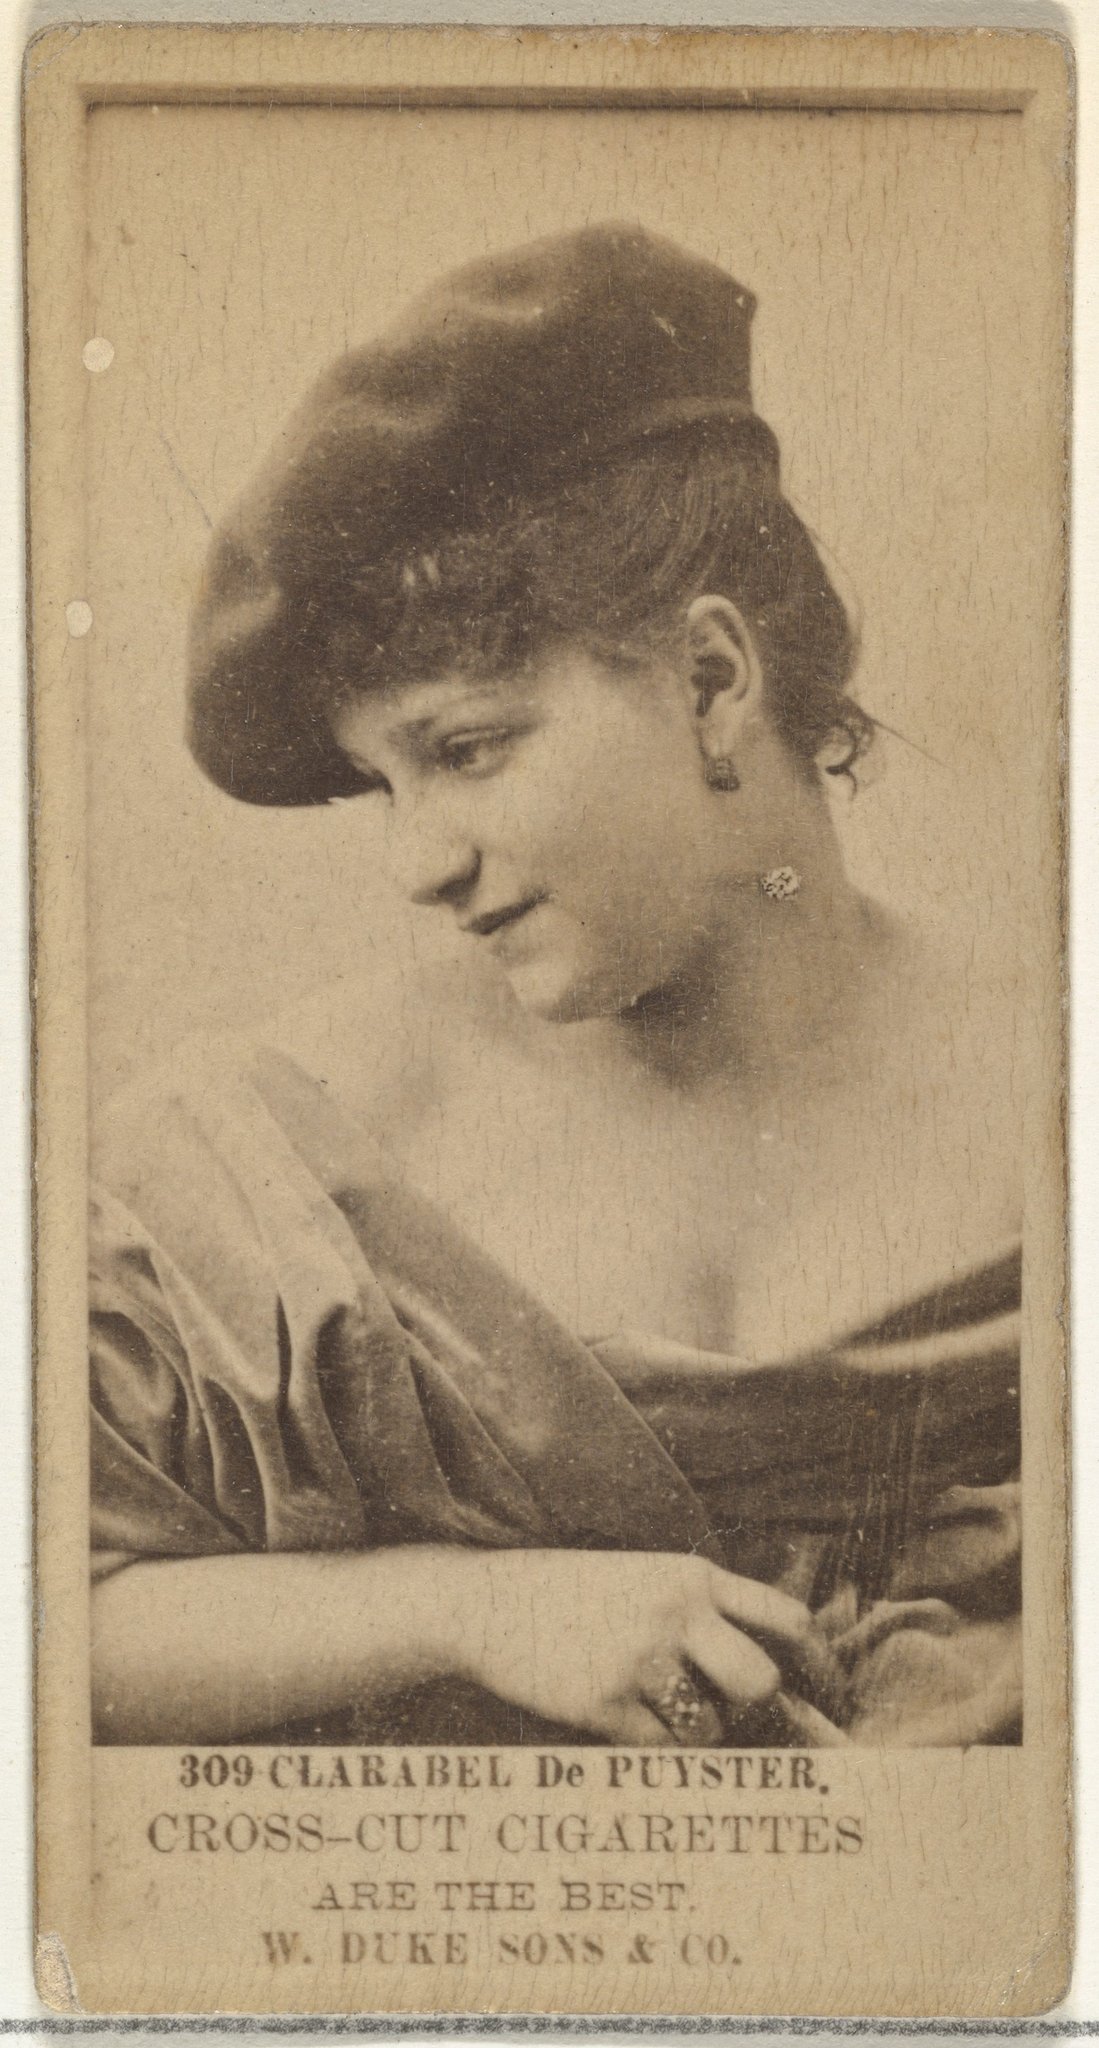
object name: photograph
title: Card Number 309, Clarabel De Puyster, from the Actors and Actresses series (N145-3) issued by Duke Sons & Co. to promote Cross Cut Cigarettes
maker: w. duke, sons & co.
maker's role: publisher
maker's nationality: american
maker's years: 1870-1920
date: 1880-1889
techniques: albumen silver print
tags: women,actresses